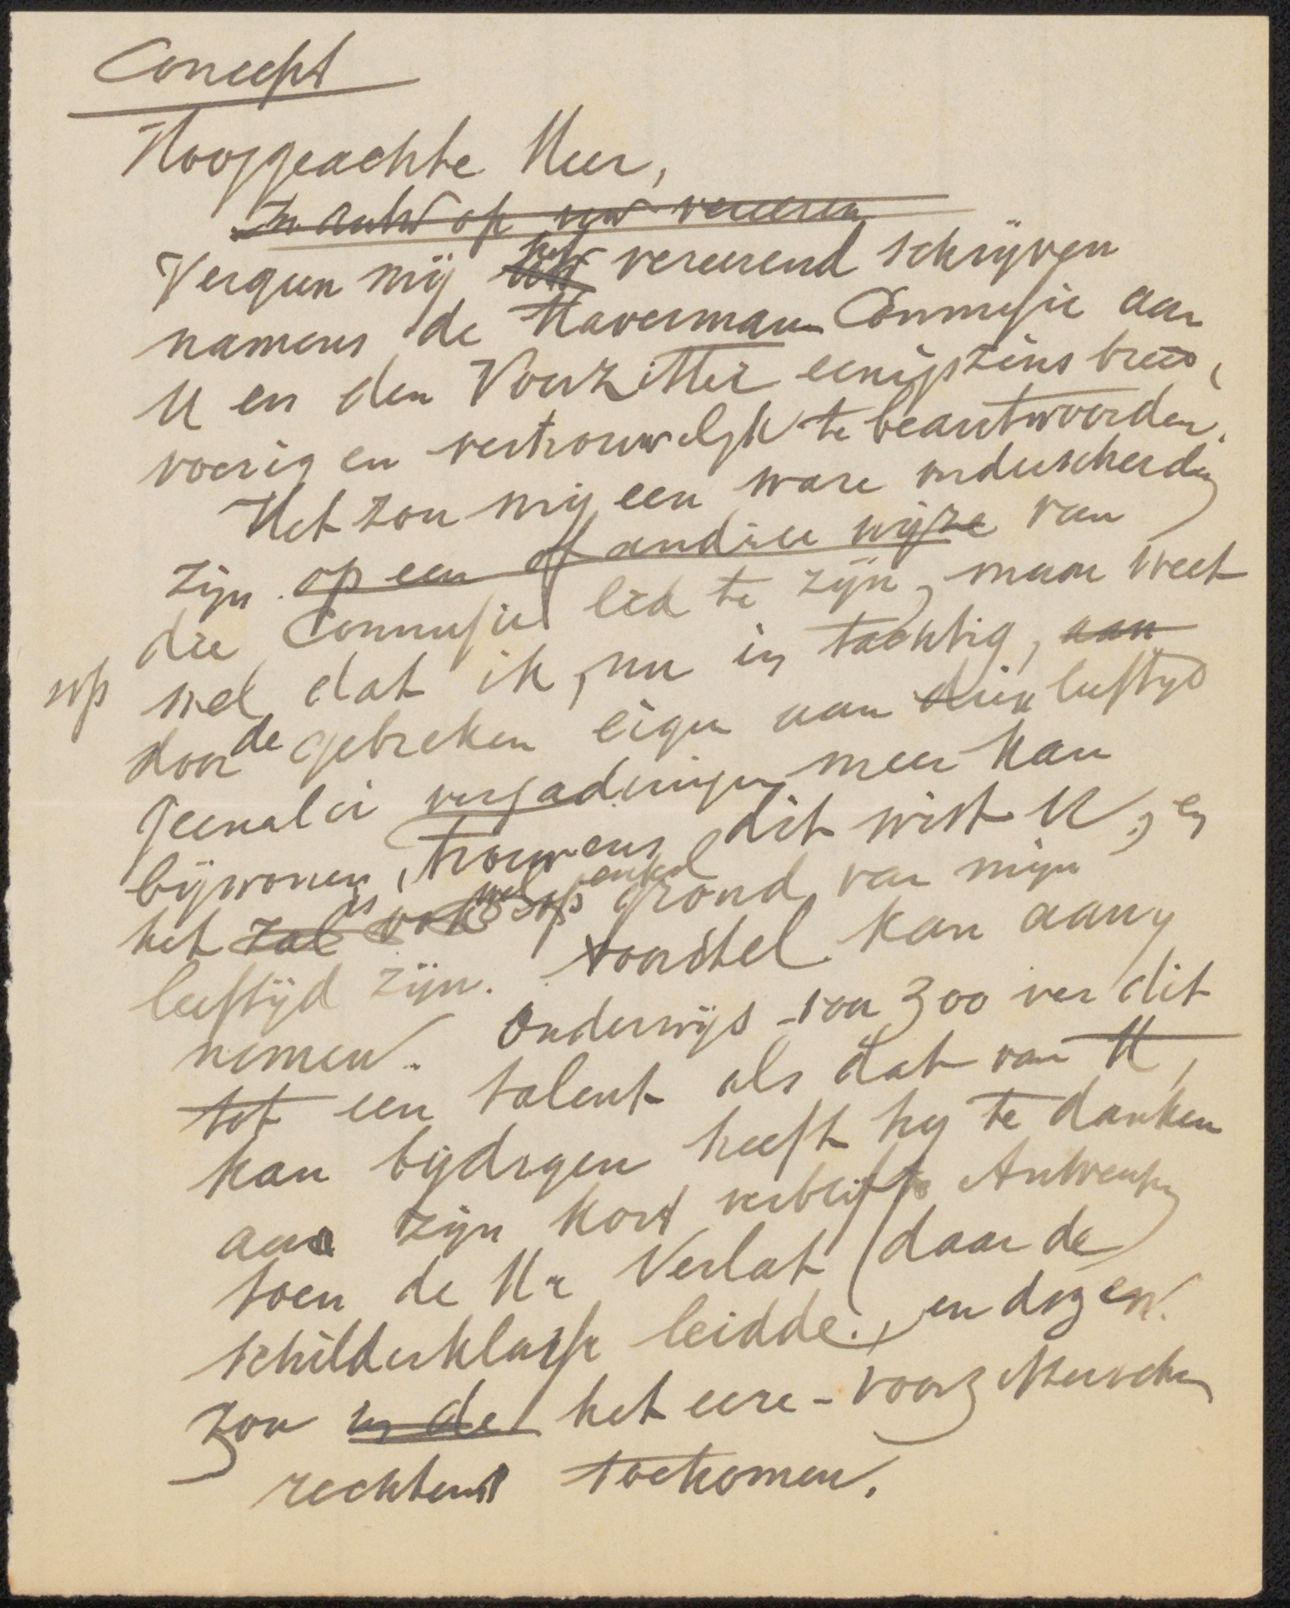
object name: letter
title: Conceptbrief aan anoniem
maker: august allebé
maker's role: draughtsman, print maker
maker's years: 1838-1927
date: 1848-1927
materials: ink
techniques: pen, writing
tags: painter, print maker, charles verlat, the hague, draughtsman, hendrik johannes haverman, exhibition ~ art, antwerp, spain